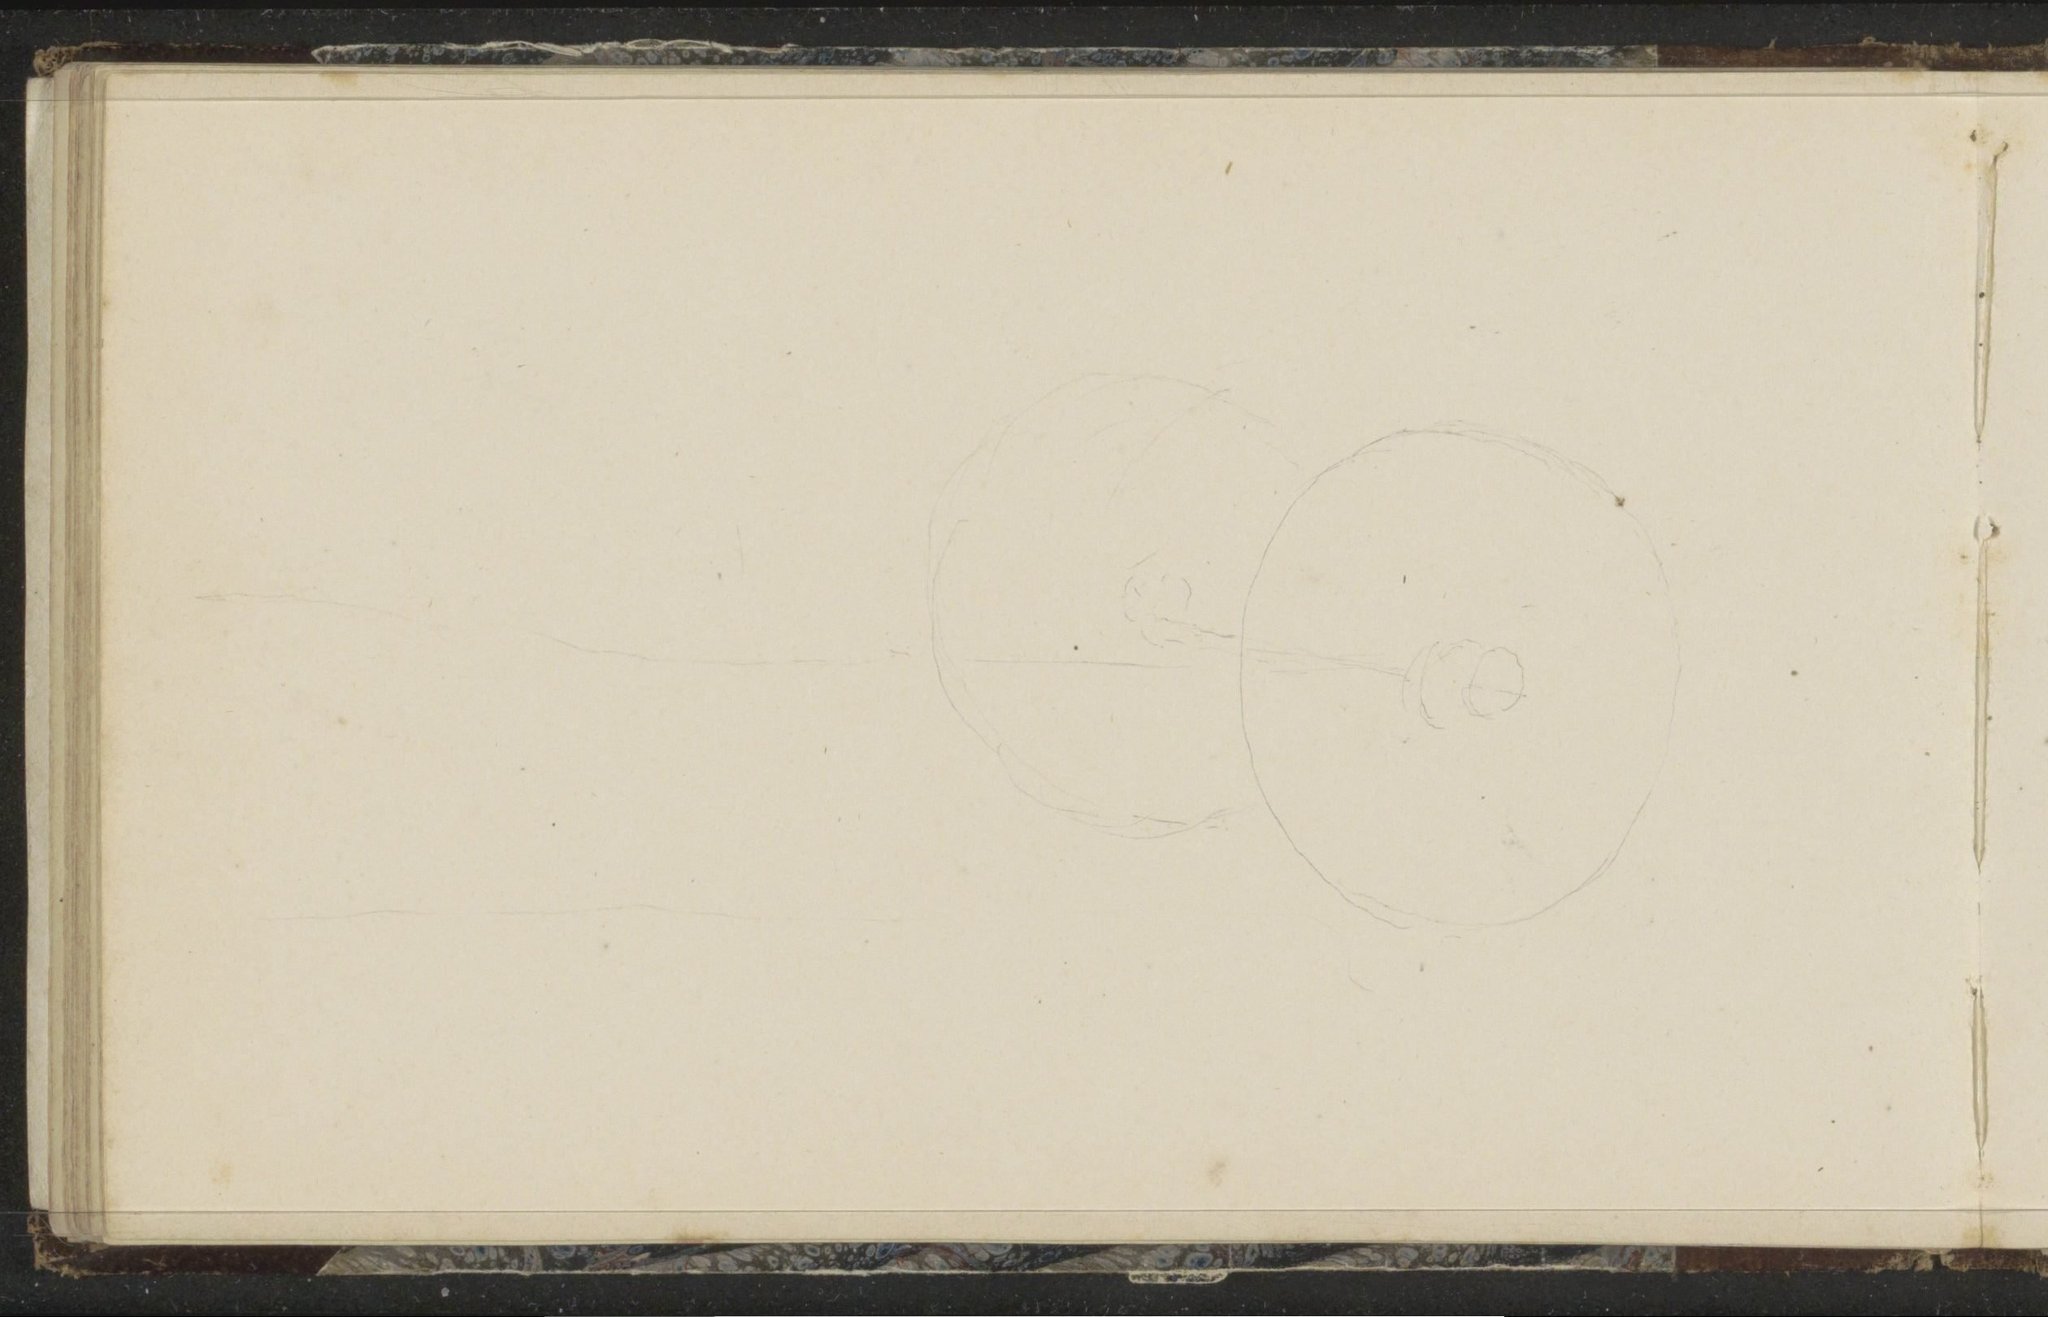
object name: sketchbook leaf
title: Cirkels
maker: christian heinrich gottlieb steuerwald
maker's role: draughtsman, print maker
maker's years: 1802-1874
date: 1845-1848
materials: paper, pencil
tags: circle (~ planimetry, geometry)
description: Blad 35 verso uit een schetsboek met 61 bladen.